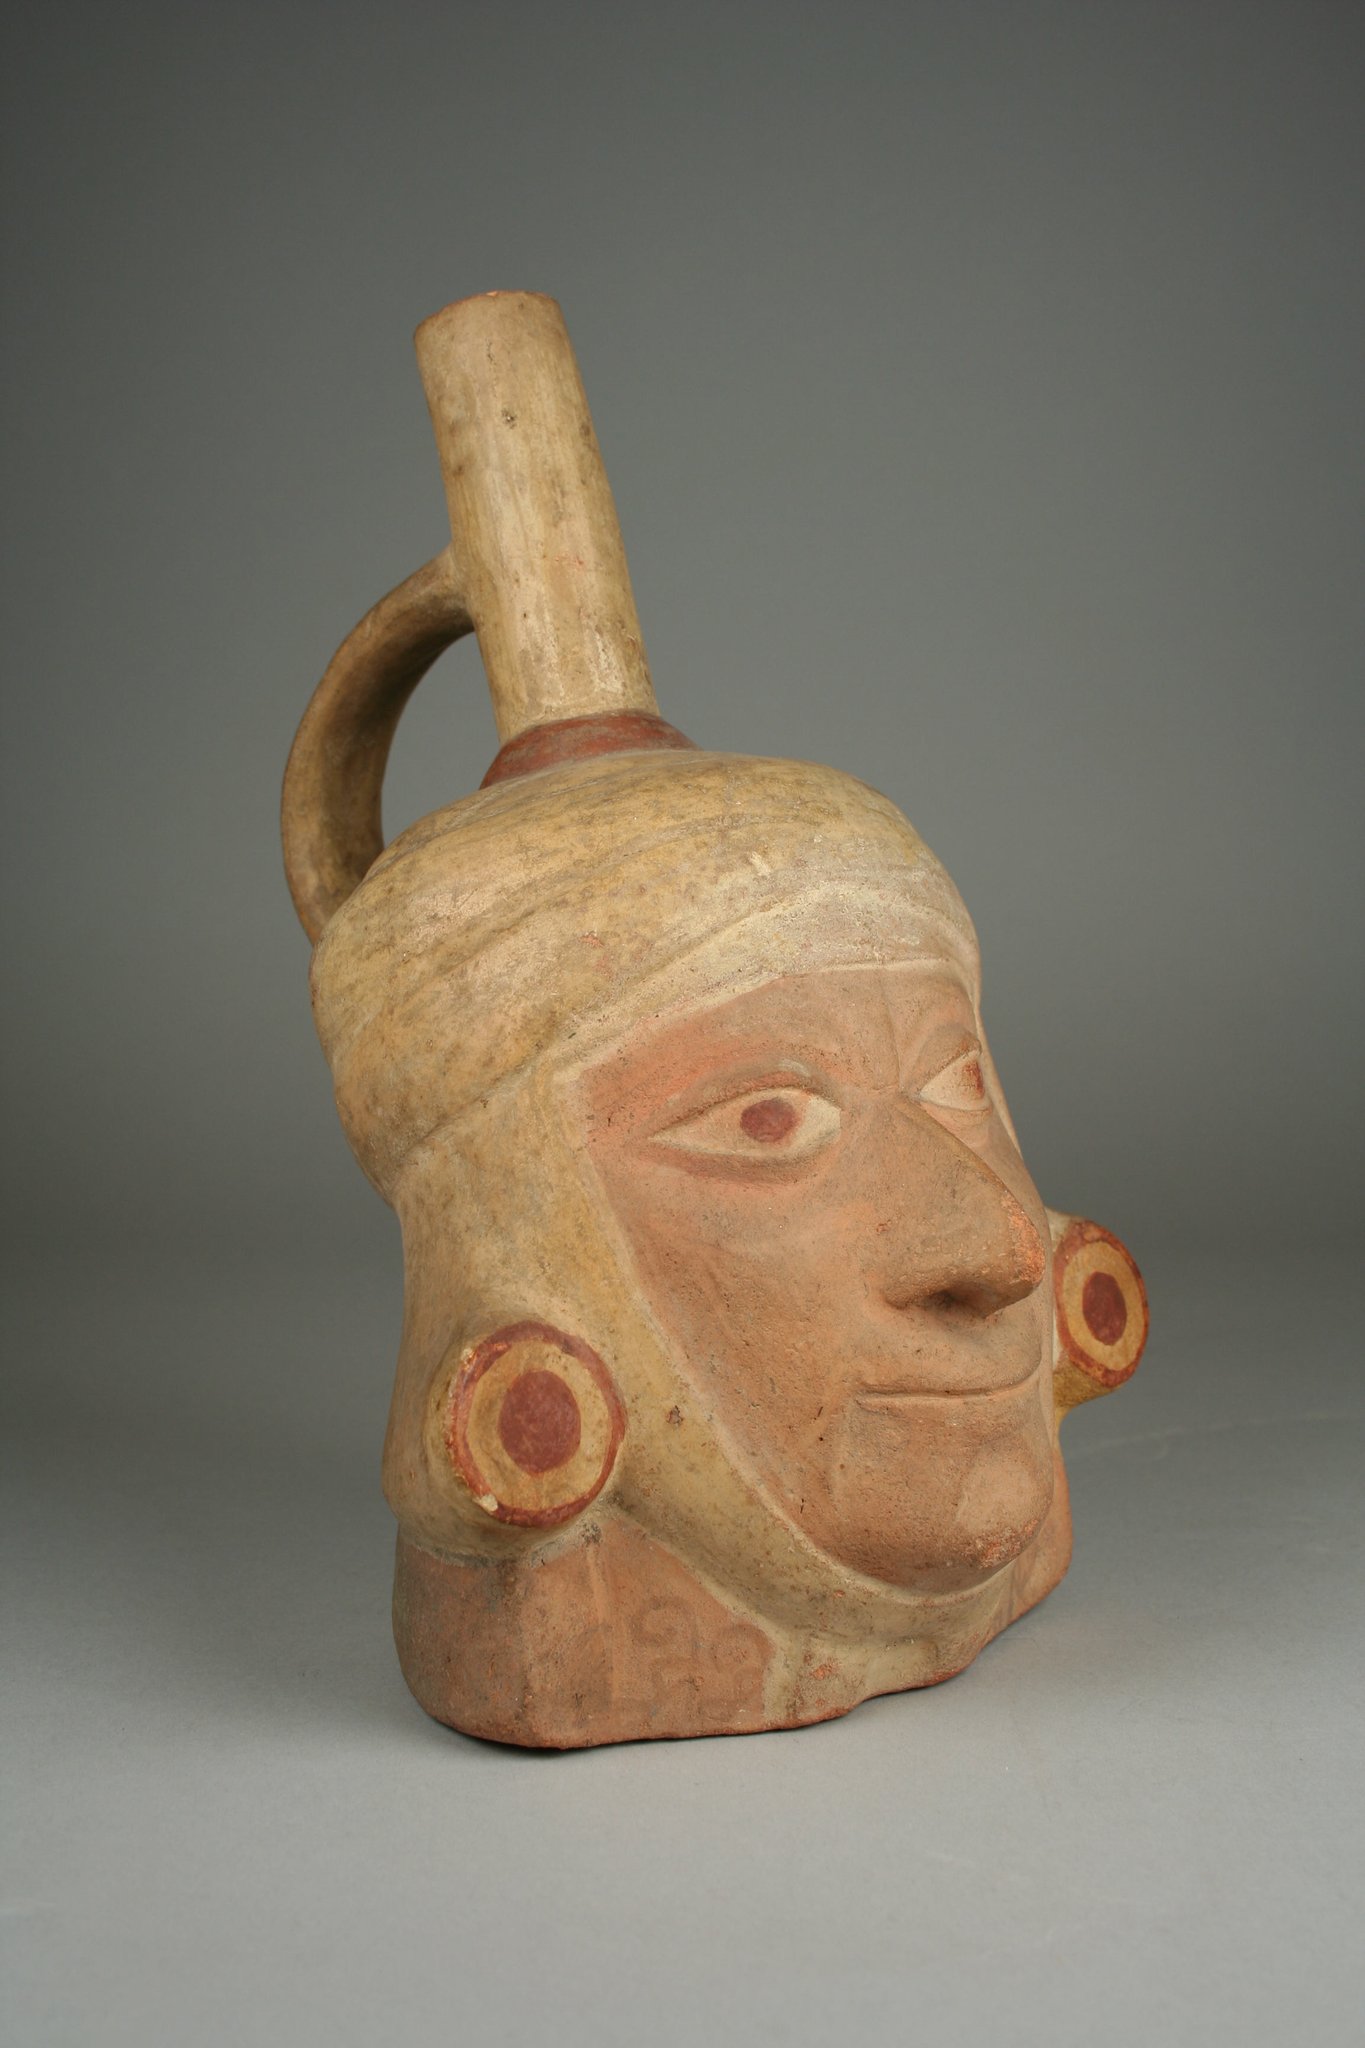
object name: bottle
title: Portrait Head Bottle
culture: moche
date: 301-700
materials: ceramic, pigment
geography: peru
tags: heads